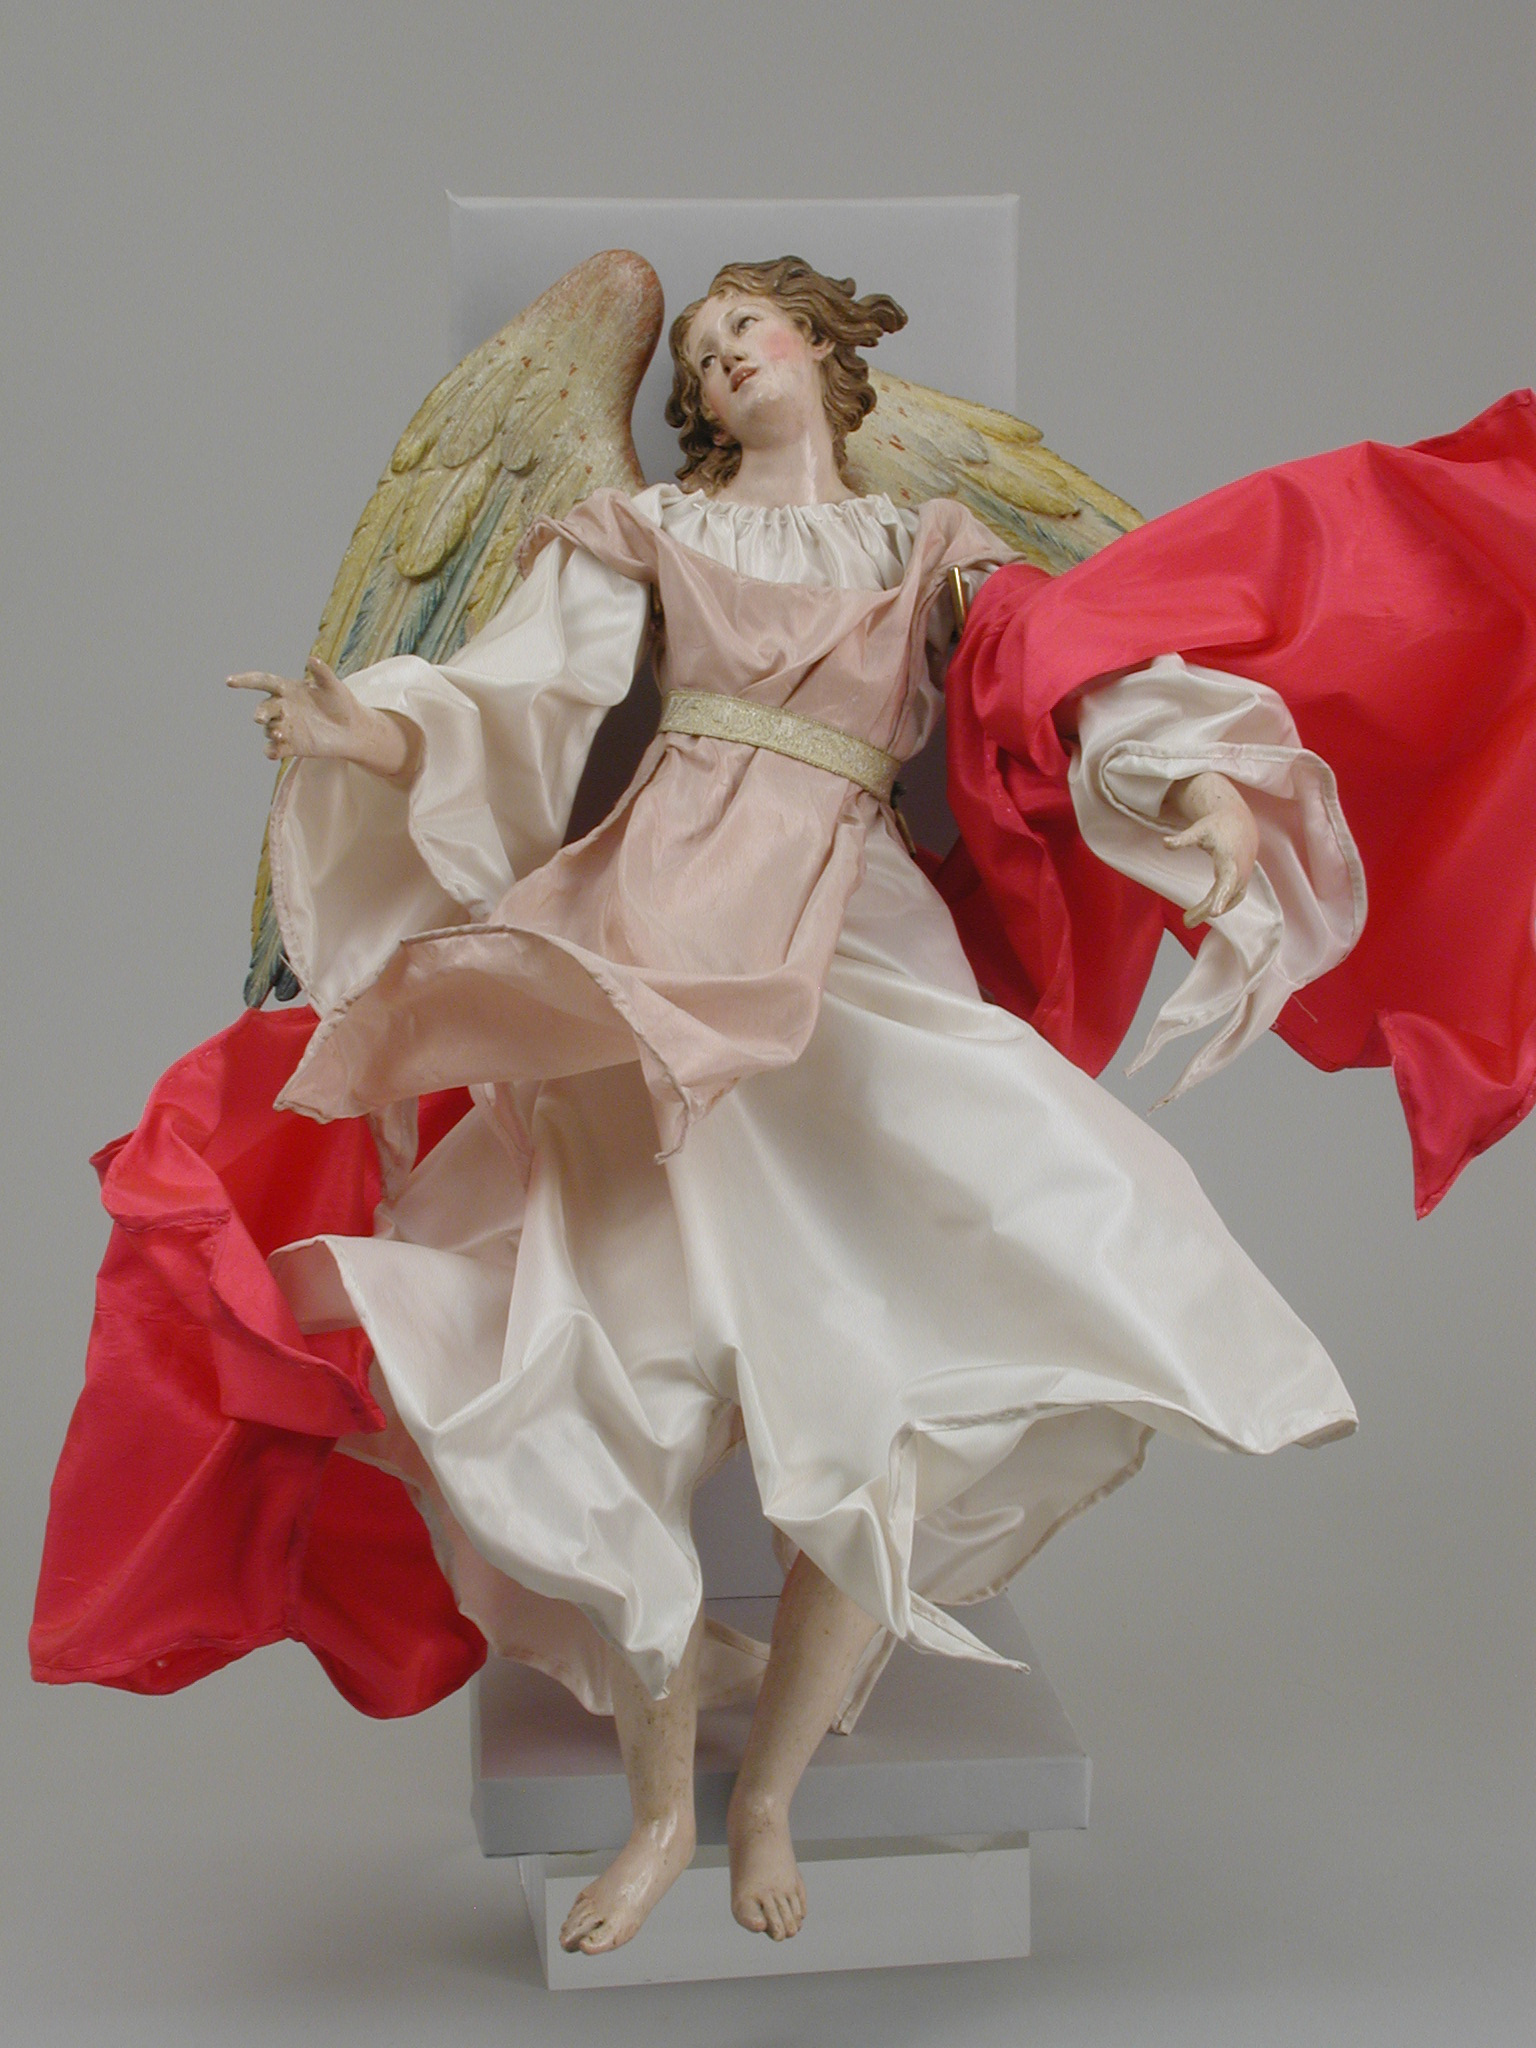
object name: crèche figure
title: Angel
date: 1701-1900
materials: fiber, terracotta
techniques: polychrome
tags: angels